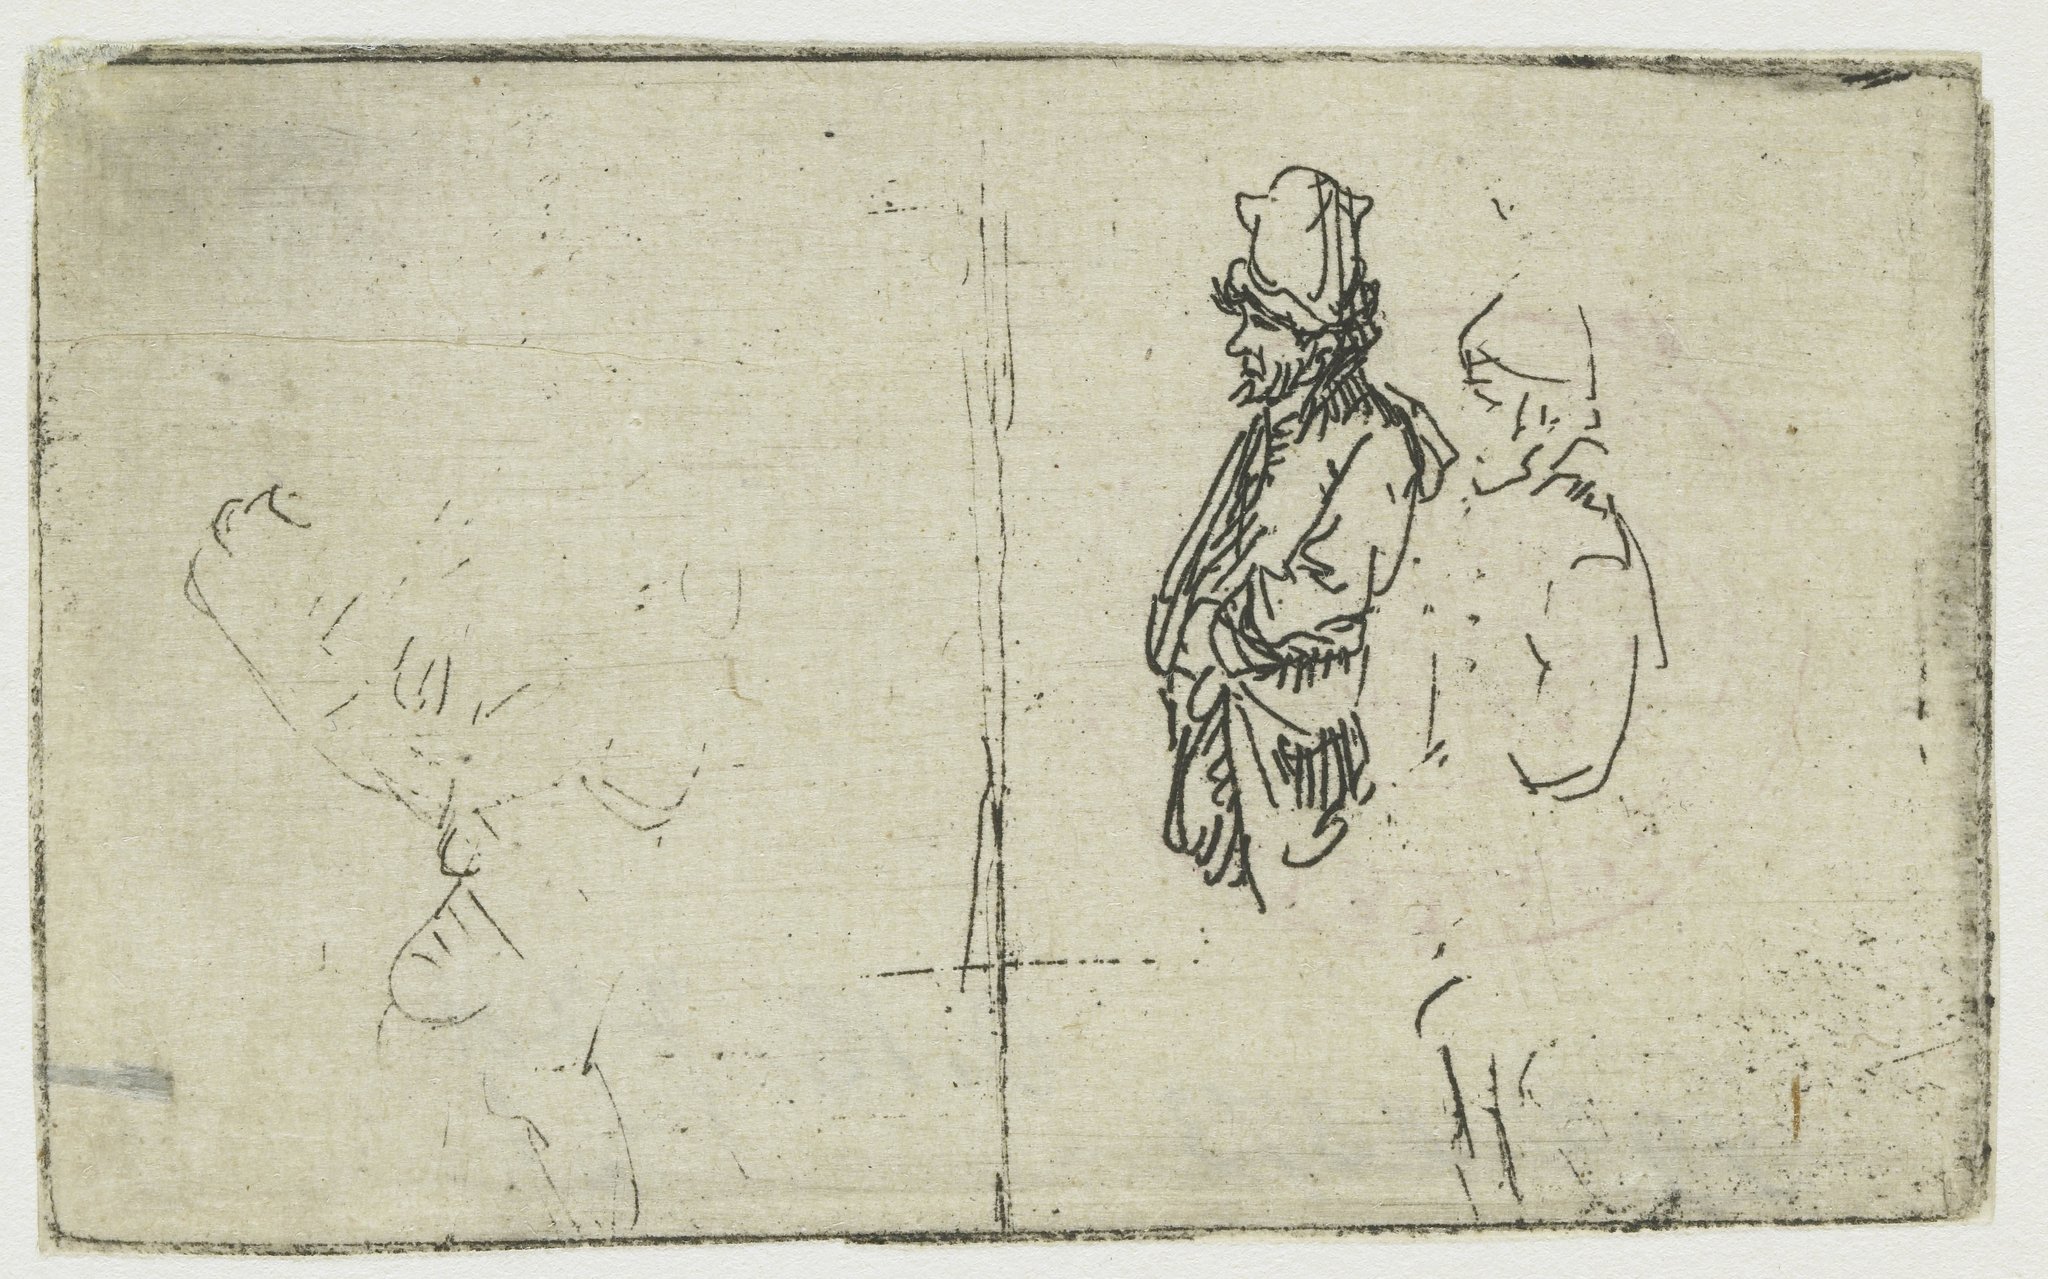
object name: print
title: Sheet of two slight studies: one of two peasants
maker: rembrandt van rijn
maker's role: draughtsman, painter, print maker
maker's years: 1606-1669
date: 1651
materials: paper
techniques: etching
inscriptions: collector's mark: Lugt 240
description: The bottom prints are among Rembrandt’s very first attempts at etching. They are not particularly skilfully etched, and their printing leaves much to be desired. They were not pulled in large numbers. In fact, both are extremely rare, making the fact that they survived for centuries all the more noteworthy. They bear unmistakable witness to Rembrandt’s early fascination with street people.